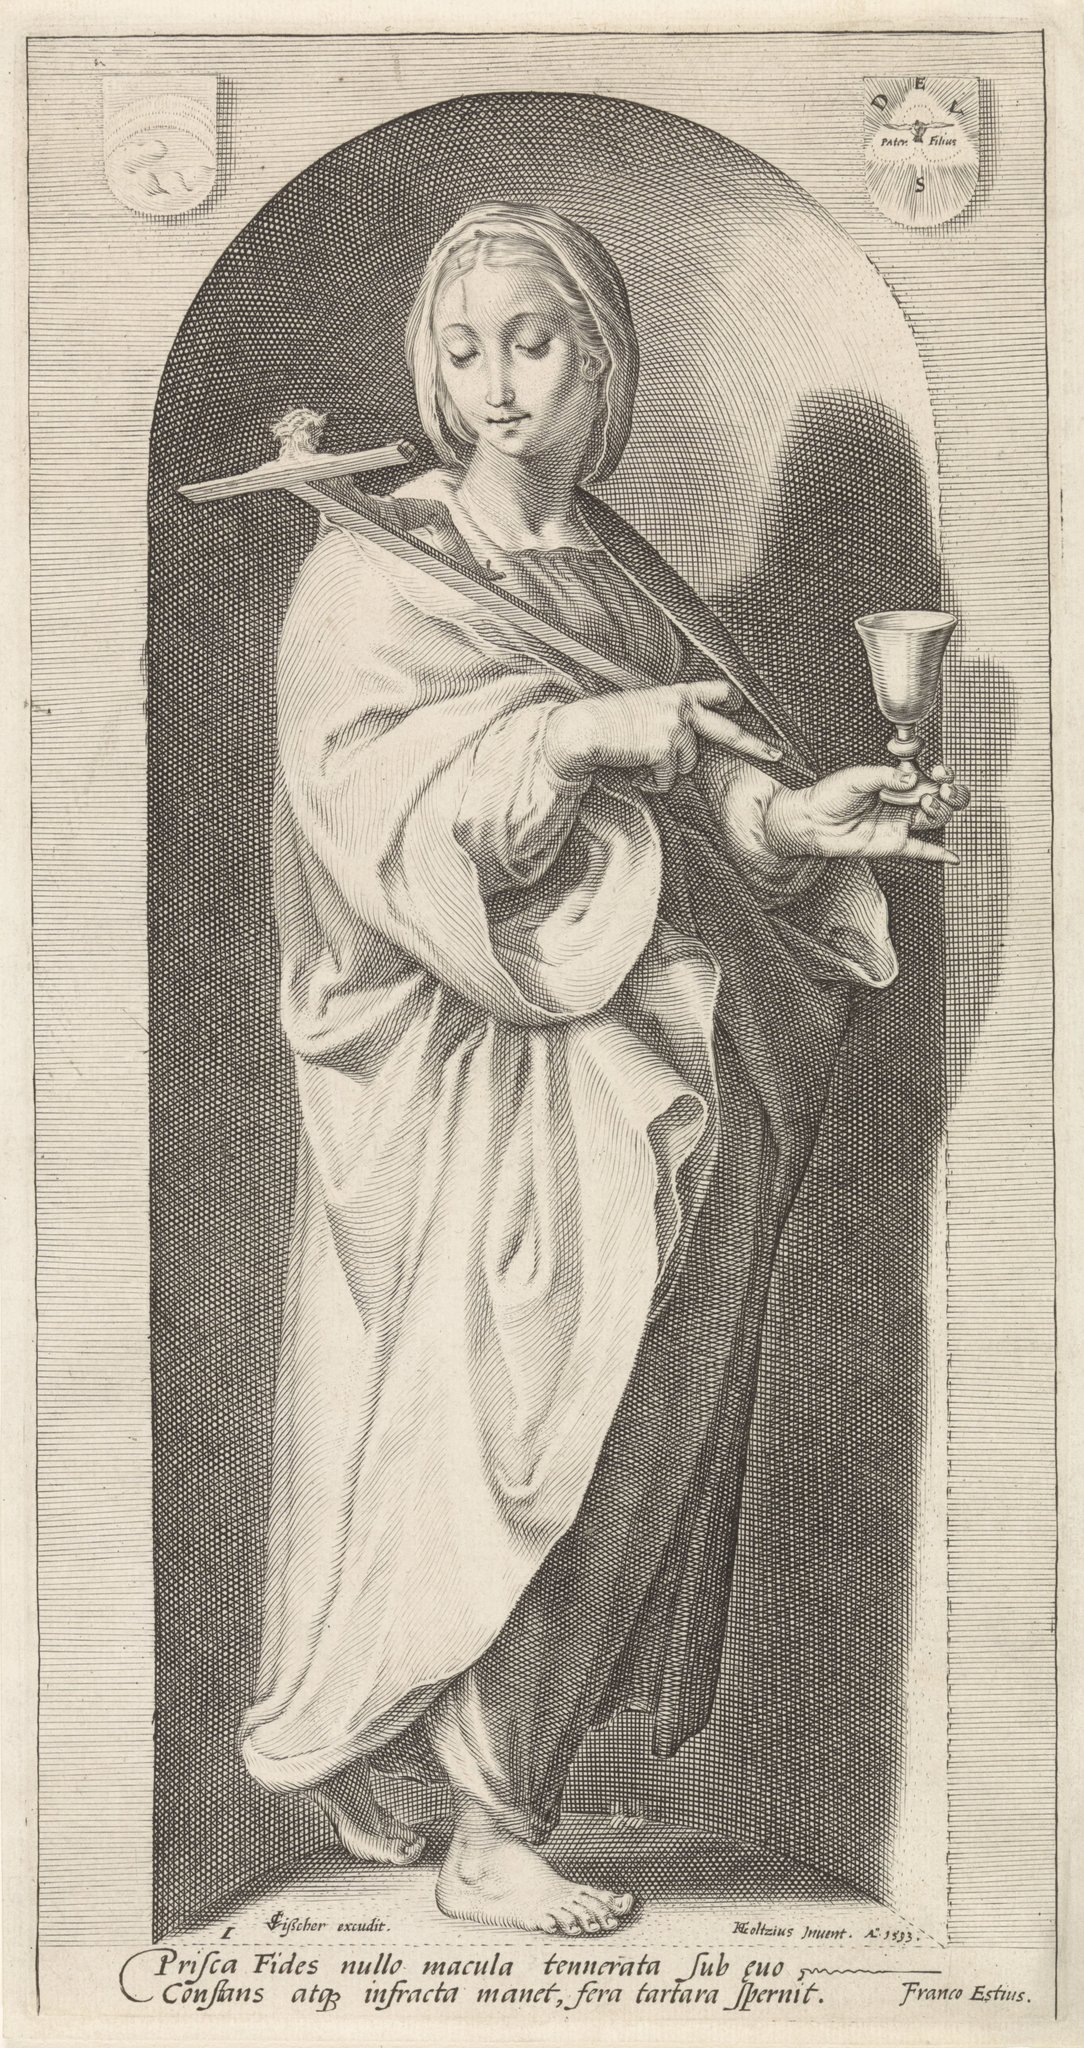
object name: print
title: De zeven hoofddeugden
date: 1593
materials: paper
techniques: engraving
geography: haarlem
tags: faith, 'fides'; 'fede', 'fede catholica', 'fede christiana', 'fede christiana catholica' (ripa) ~ one of the three theological virtues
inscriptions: collector's mark: Lugt 2228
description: Personificatie van het geloof, met crucifix en kelk, staand in nis.